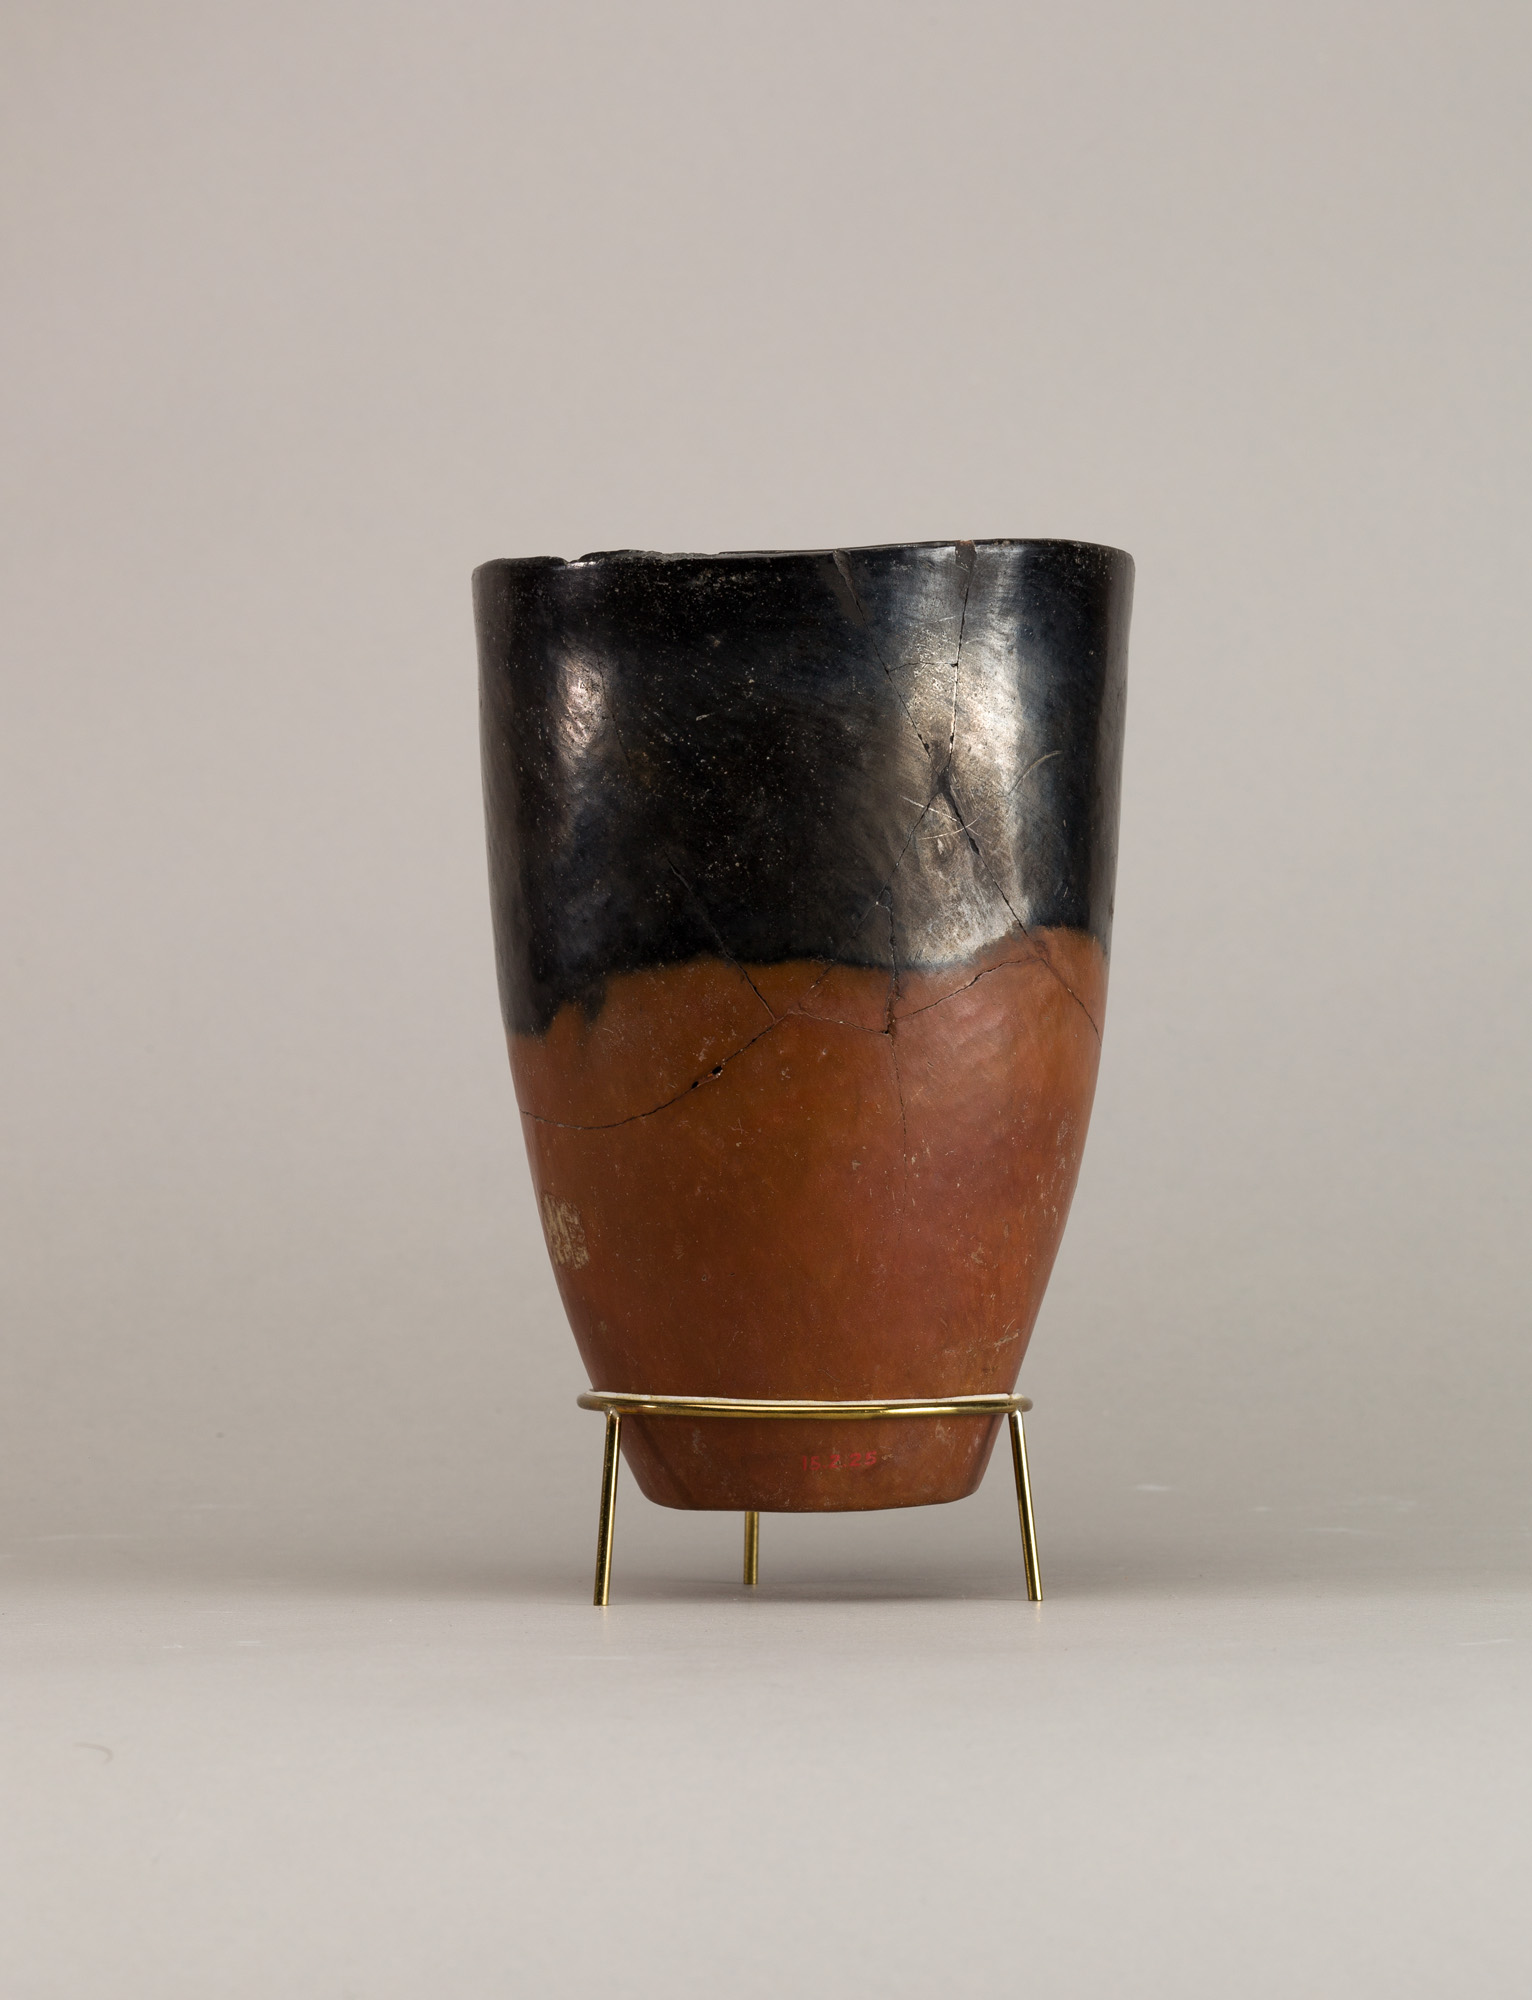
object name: beaker, black topped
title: Black-topped Red Ware Beaker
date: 3850-2960 BCE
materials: pottery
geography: egypt